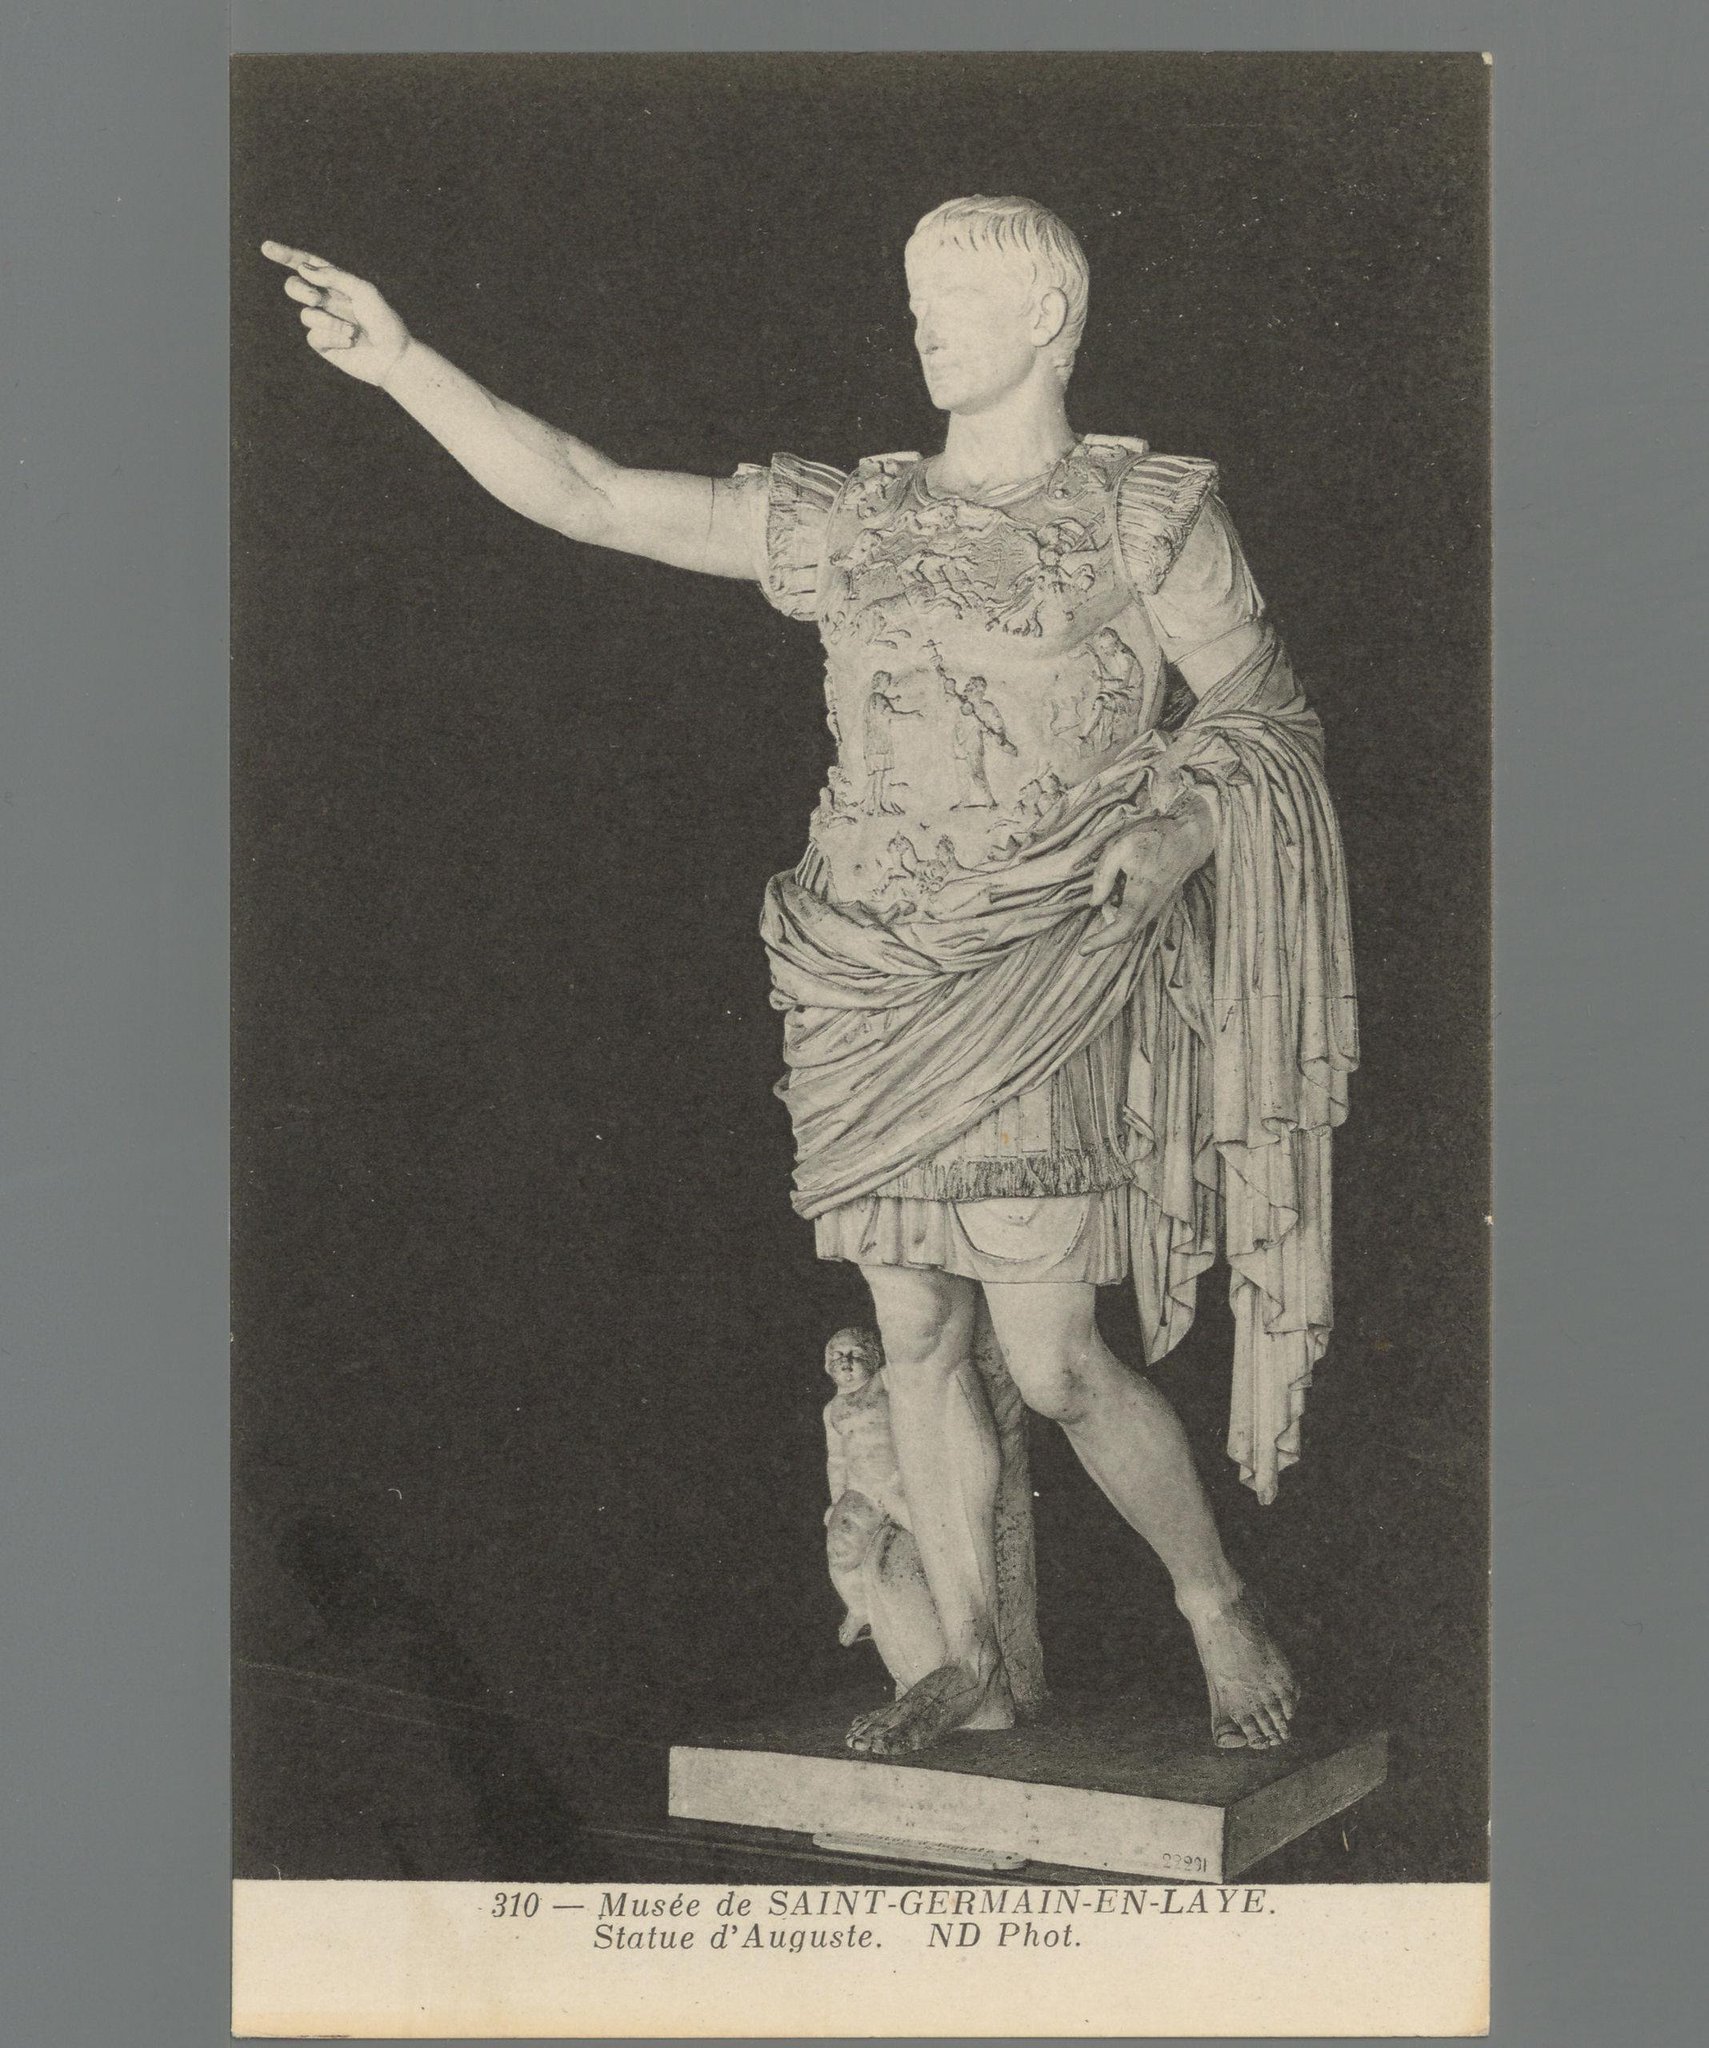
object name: photomechanical print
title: Statue d'Auguste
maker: Anonymous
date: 1903-1918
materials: cardboard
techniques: photograph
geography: saint-germain-en-laye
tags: monument, statue, permanent exhibition, museum